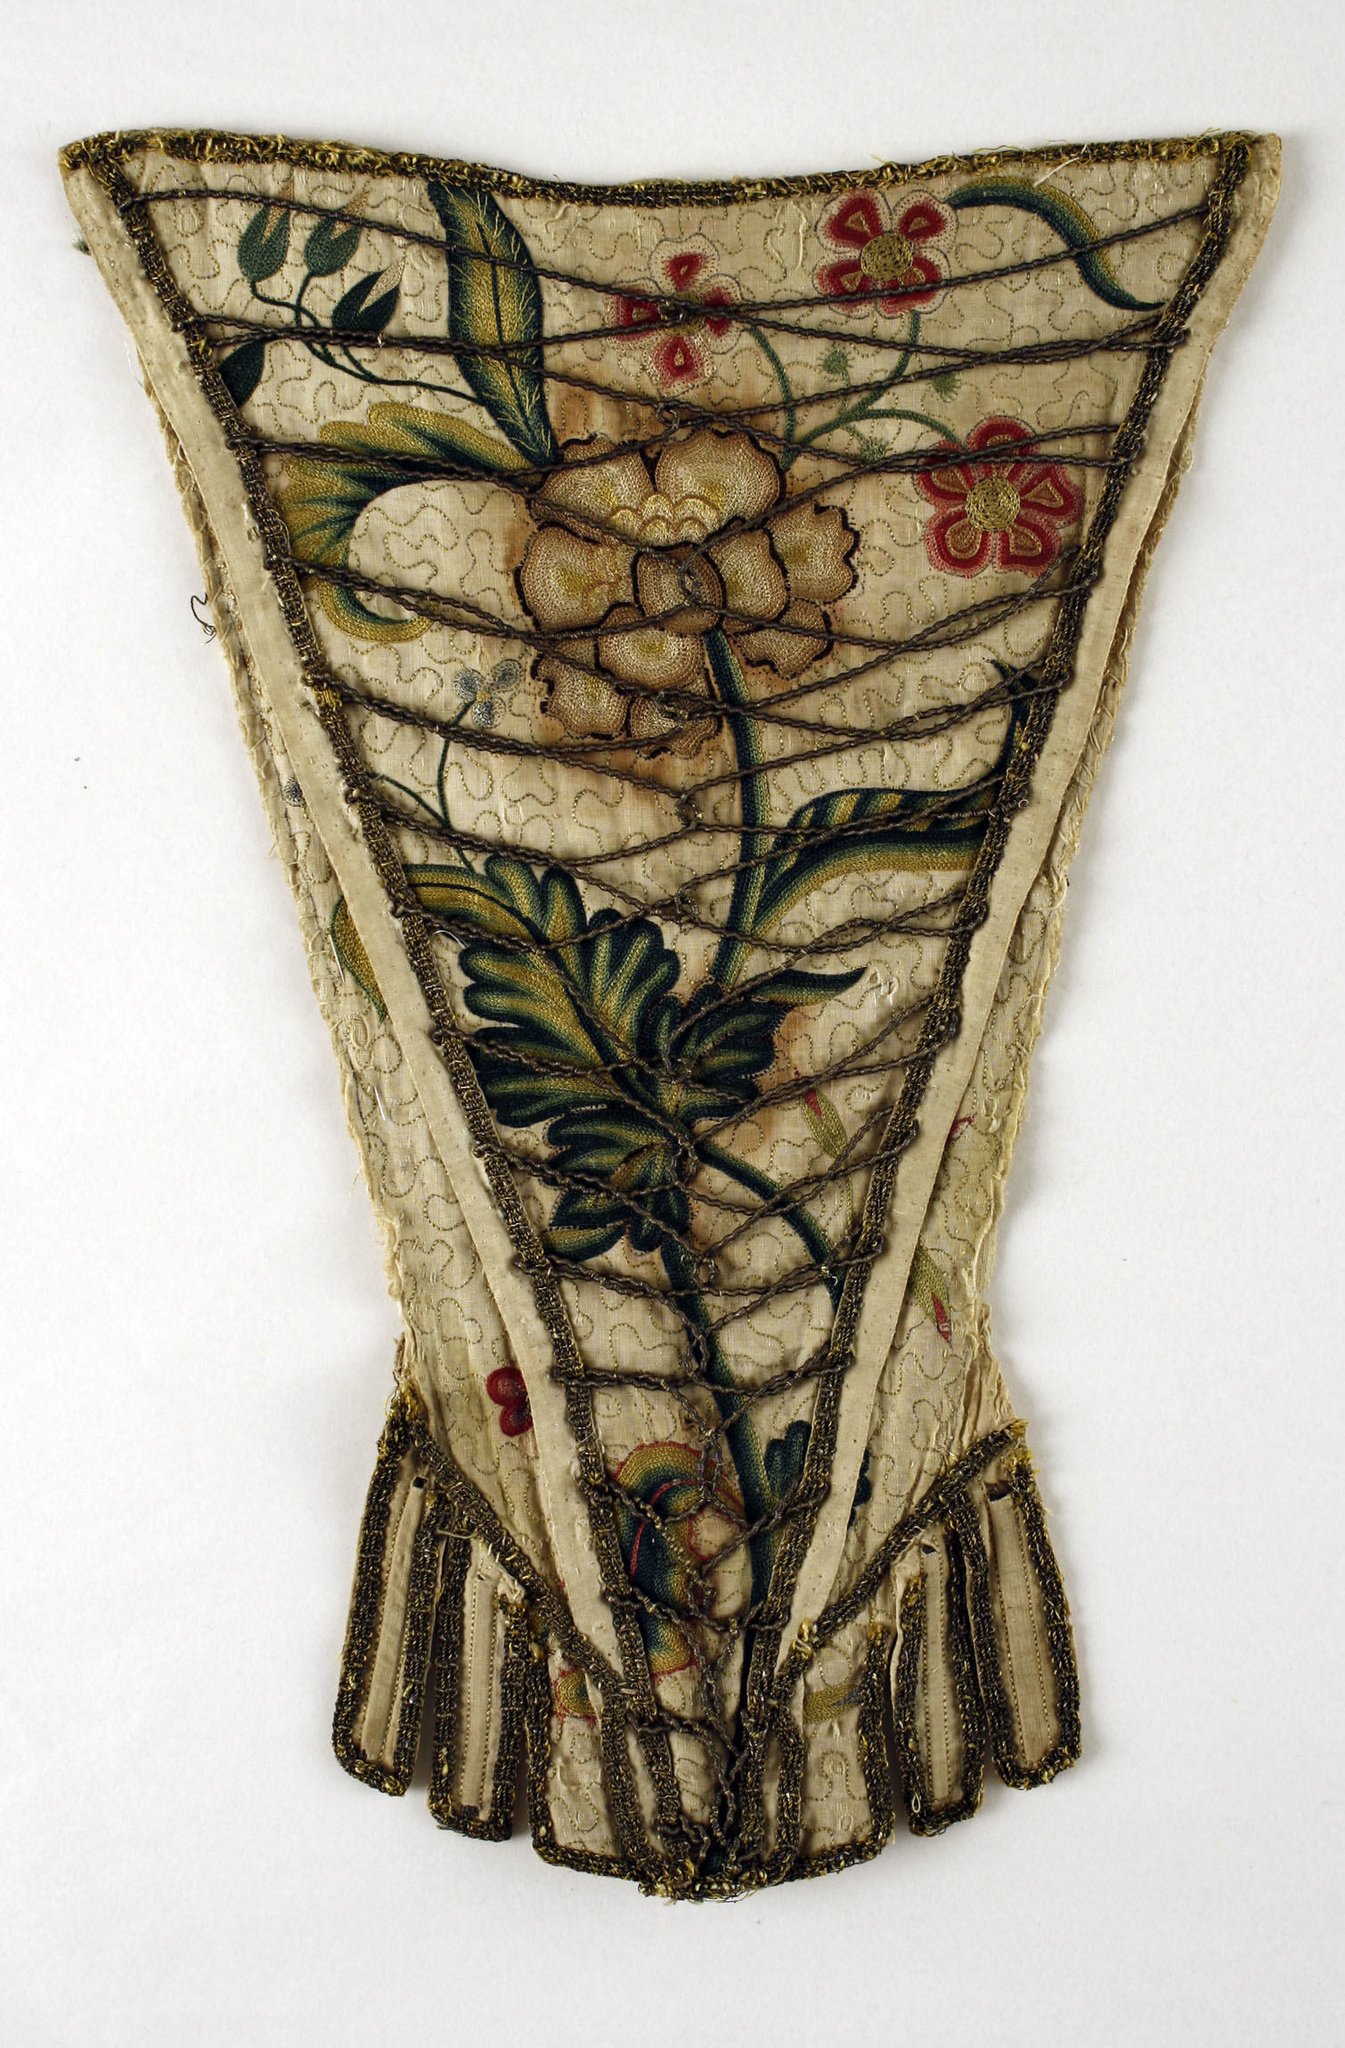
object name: stomacher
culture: british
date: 1701-1725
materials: bone, linen, silk